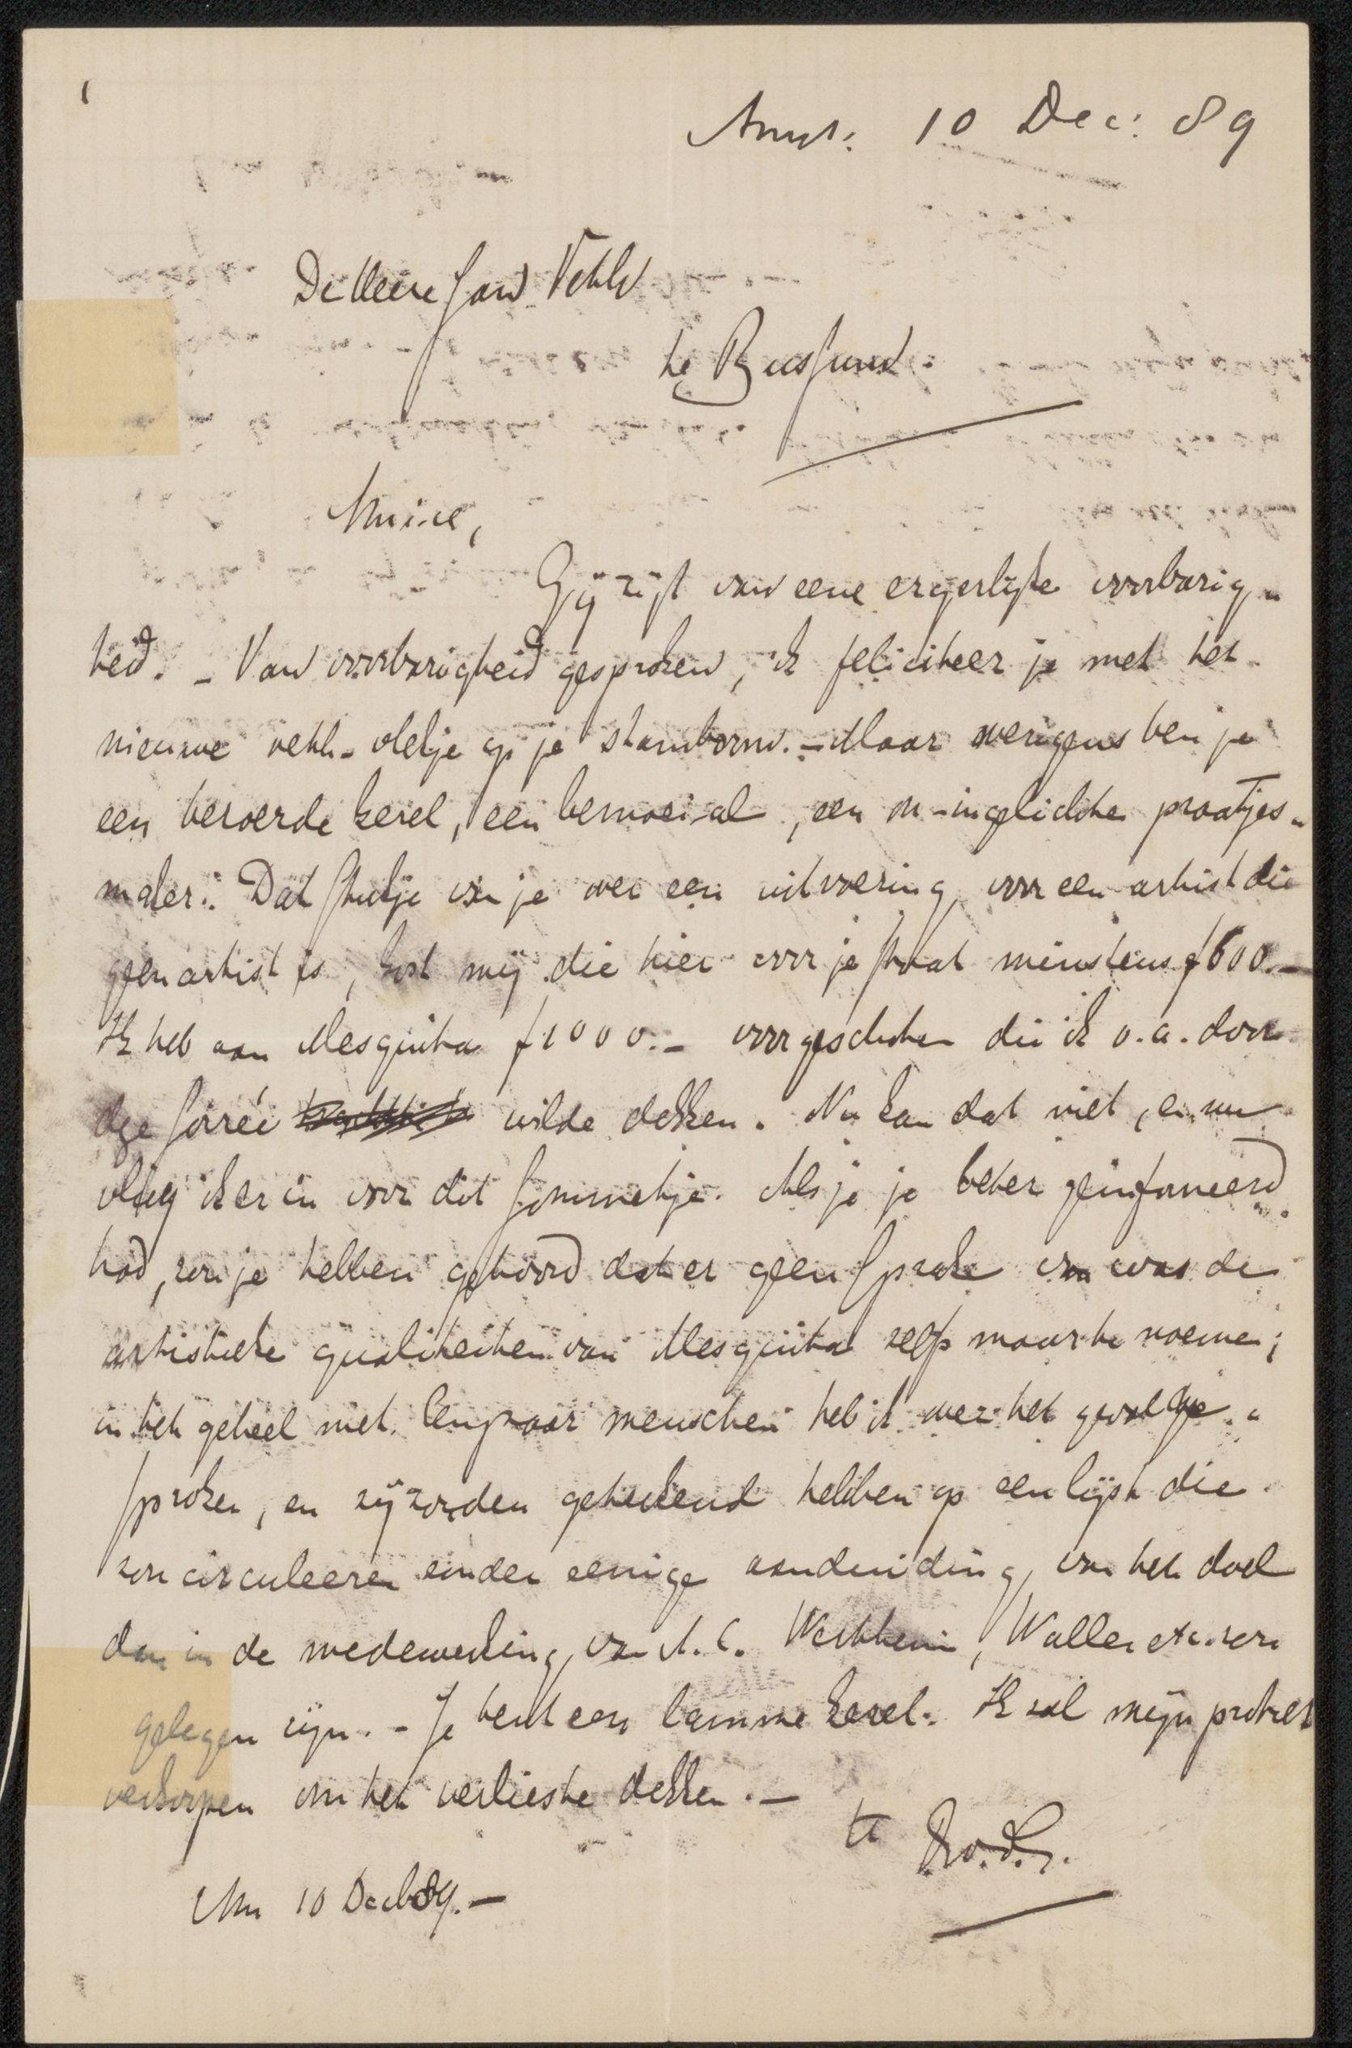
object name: letter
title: Brief aan Jan Veth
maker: frank van der goes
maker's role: letterkundige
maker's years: 1859-1939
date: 1889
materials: ink, paper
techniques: pen, writing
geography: amsterdam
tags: dordrecht, painter, jan veth, amsterdam, politician, art trade, art shop, family life, money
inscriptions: collector's mark: ‘RPK’